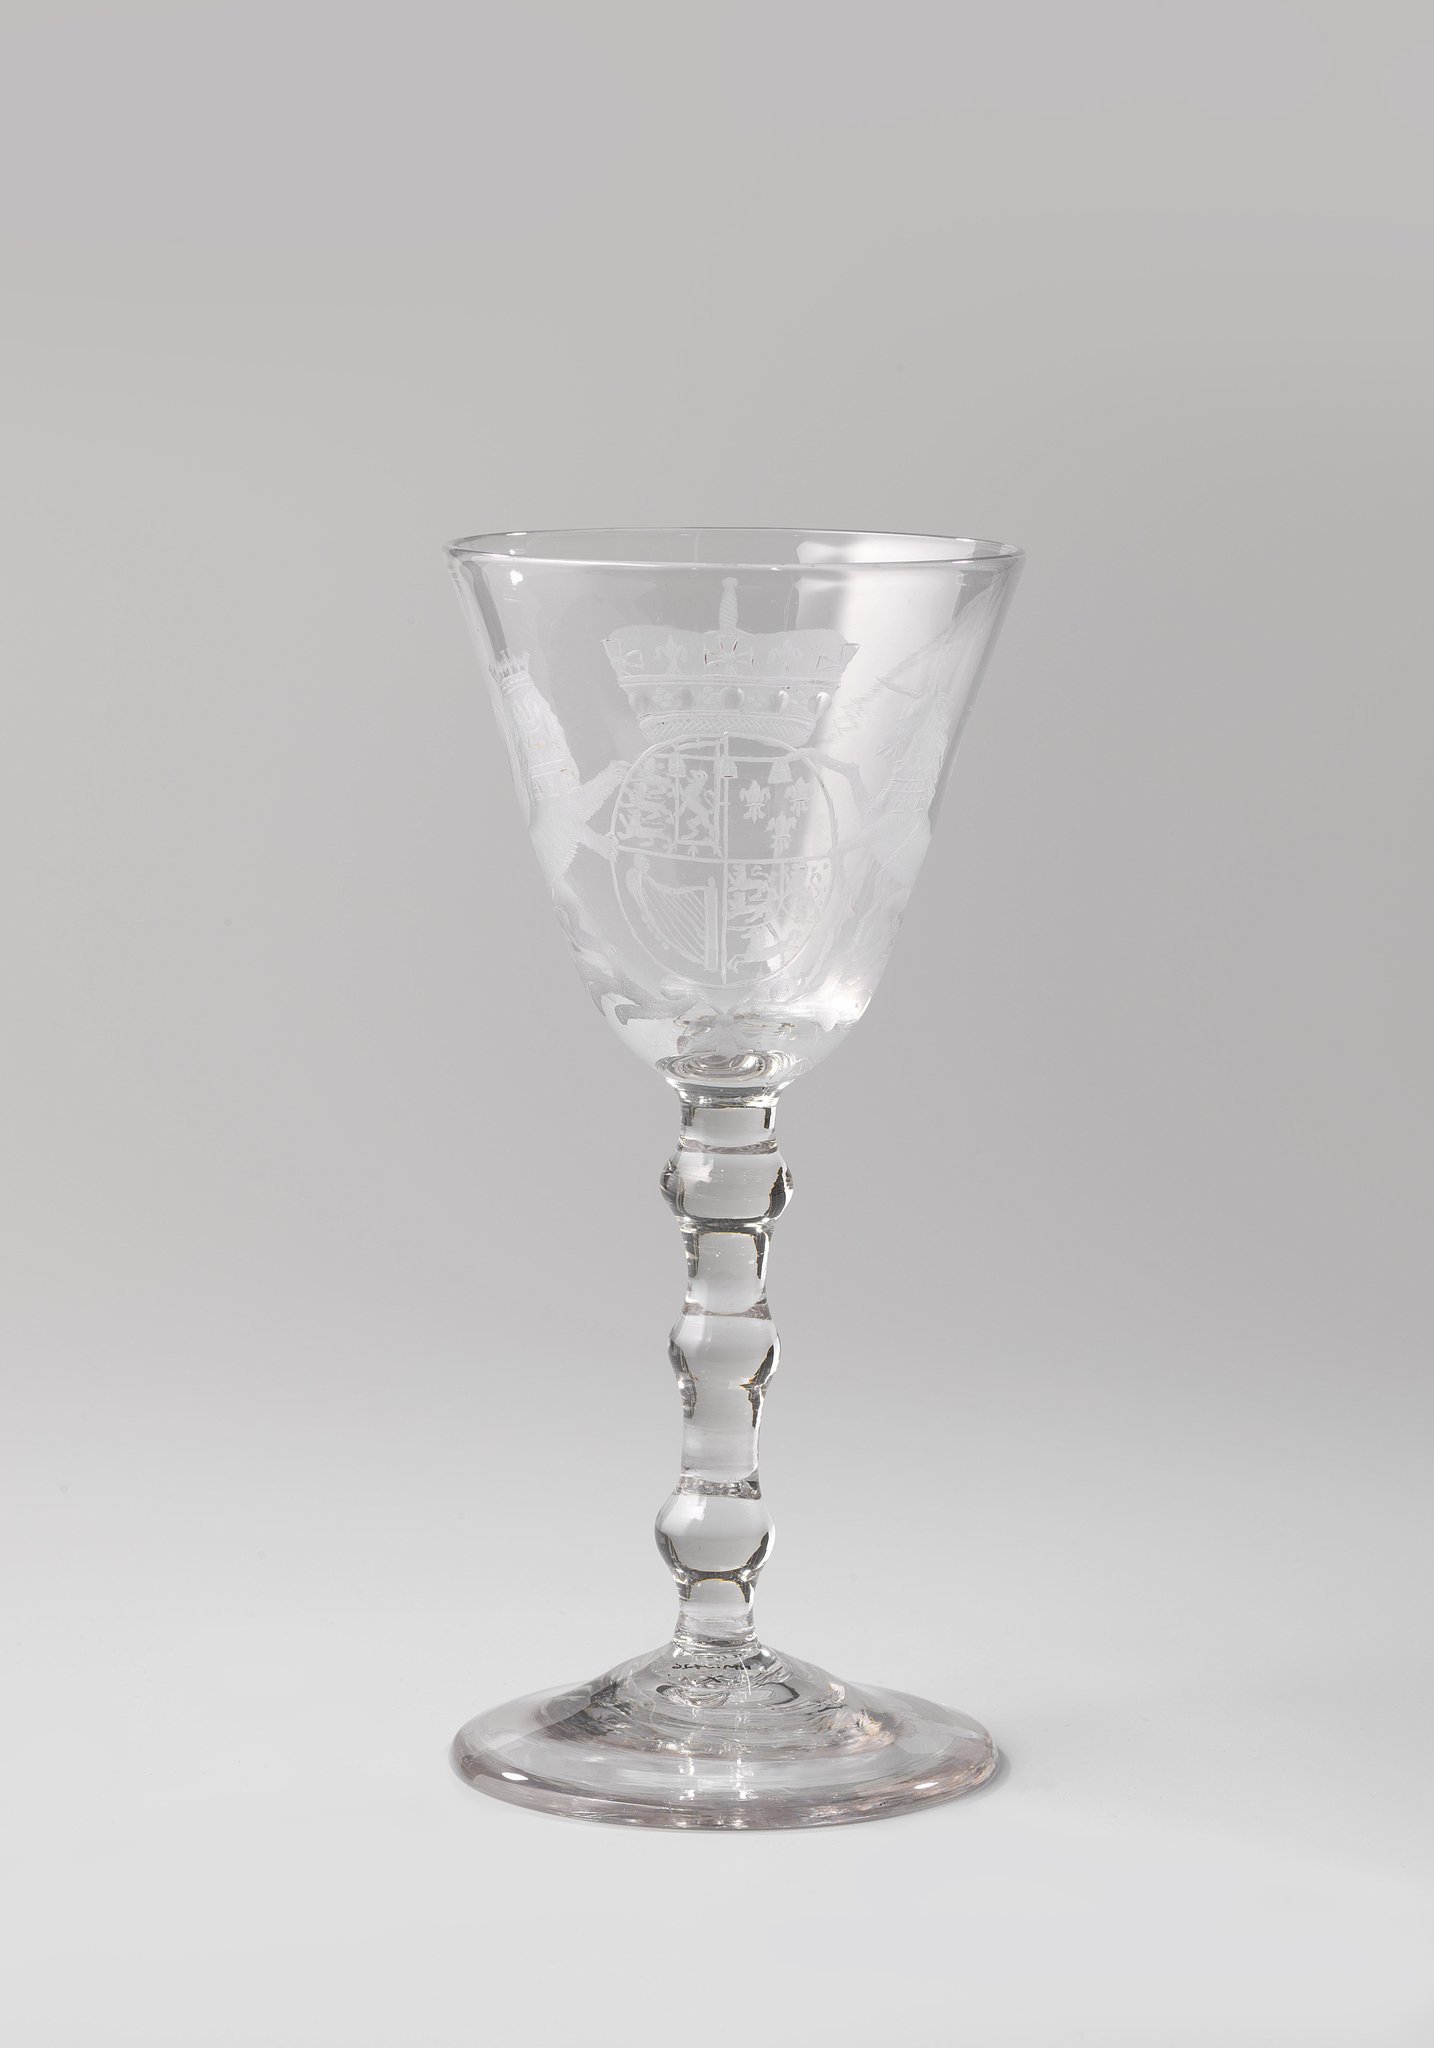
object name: goblet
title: Bokaal met het wapen van Anna van Hannover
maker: Anonymous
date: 1735-1750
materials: glass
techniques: glassblowing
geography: northern netherlands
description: Bokaal met conische voet. Balusterstam met drie knopen. Conische kelk met het gekroonde wapen van Anna van Hannover (1709-1759).